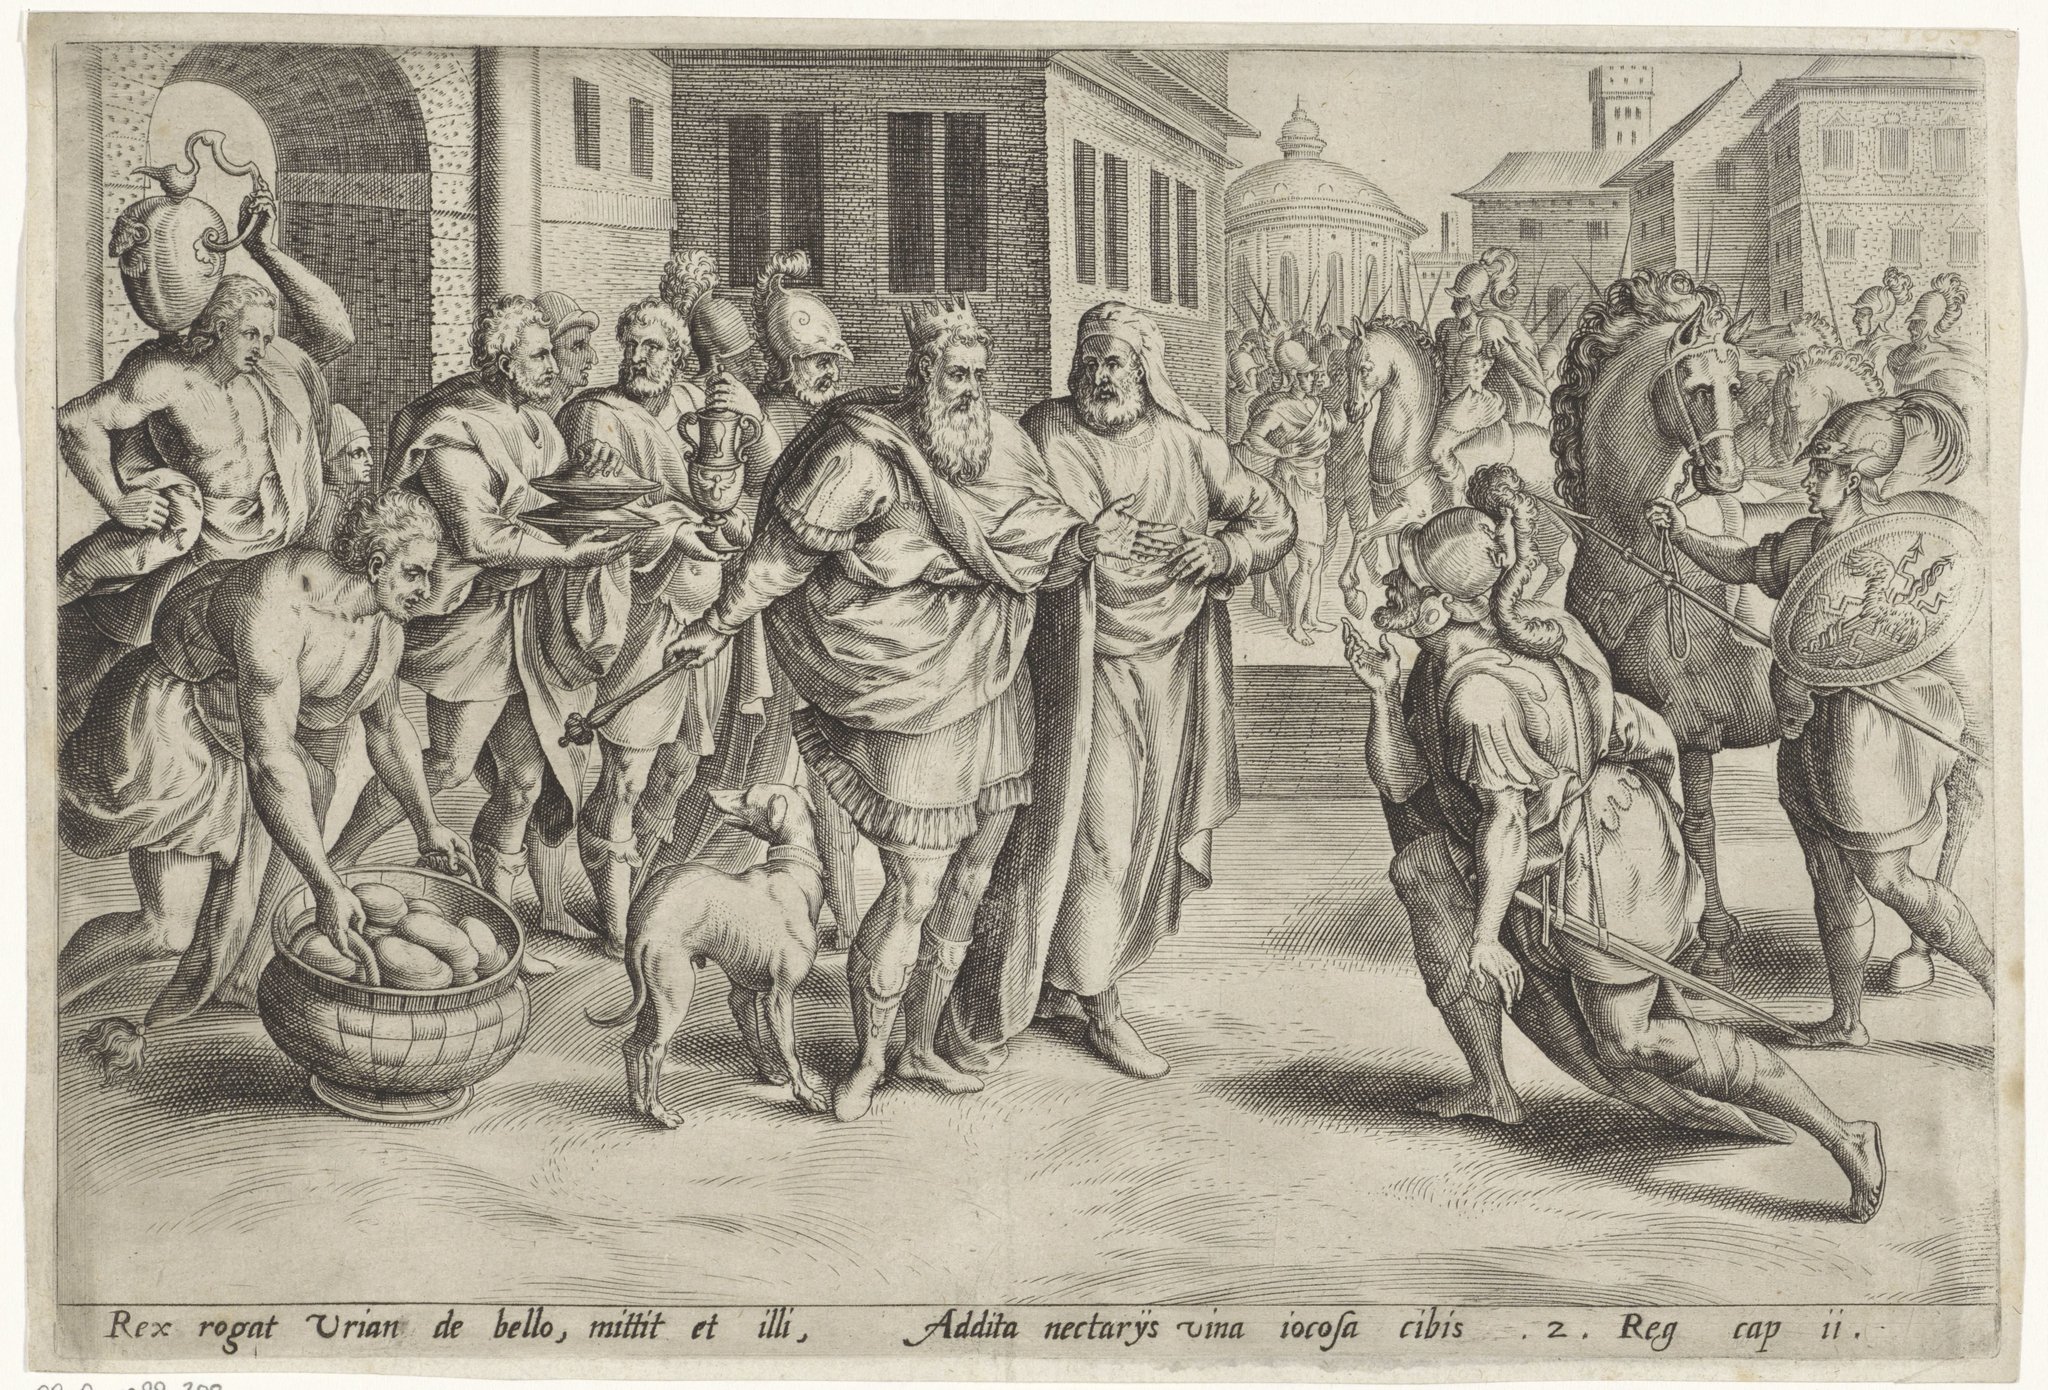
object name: print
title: Geschiedenis van David en Batseba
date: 1579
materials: paper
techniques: engraving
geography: antwerp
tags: david speaks to uriah, the soldier; the soldier's life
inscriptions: collector's mark: Lugt 2228, collector's mark: Lugt 2760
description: Prent gebruikt in: Thesaurus sacrarum historiaru veteris testamenti, elegatissimis imaginibus expressu excelletissimoru in hac arte viroru opera : nuc primu in luce editus. Antwerpen: Gerard de Jode, 1579. Of prent gebuikt in: Thesaurus sacrarum historiaru[m] veteris (et novi) testame[n]ti, elega[n]tissimis imaginibus expressu[m] excelle[n]tissimoru[m] in hac arte viroru[m] opera : nu[n]c primu[m] in luce[m] editus. Antwerpen: Gerard de Jode, 1585.